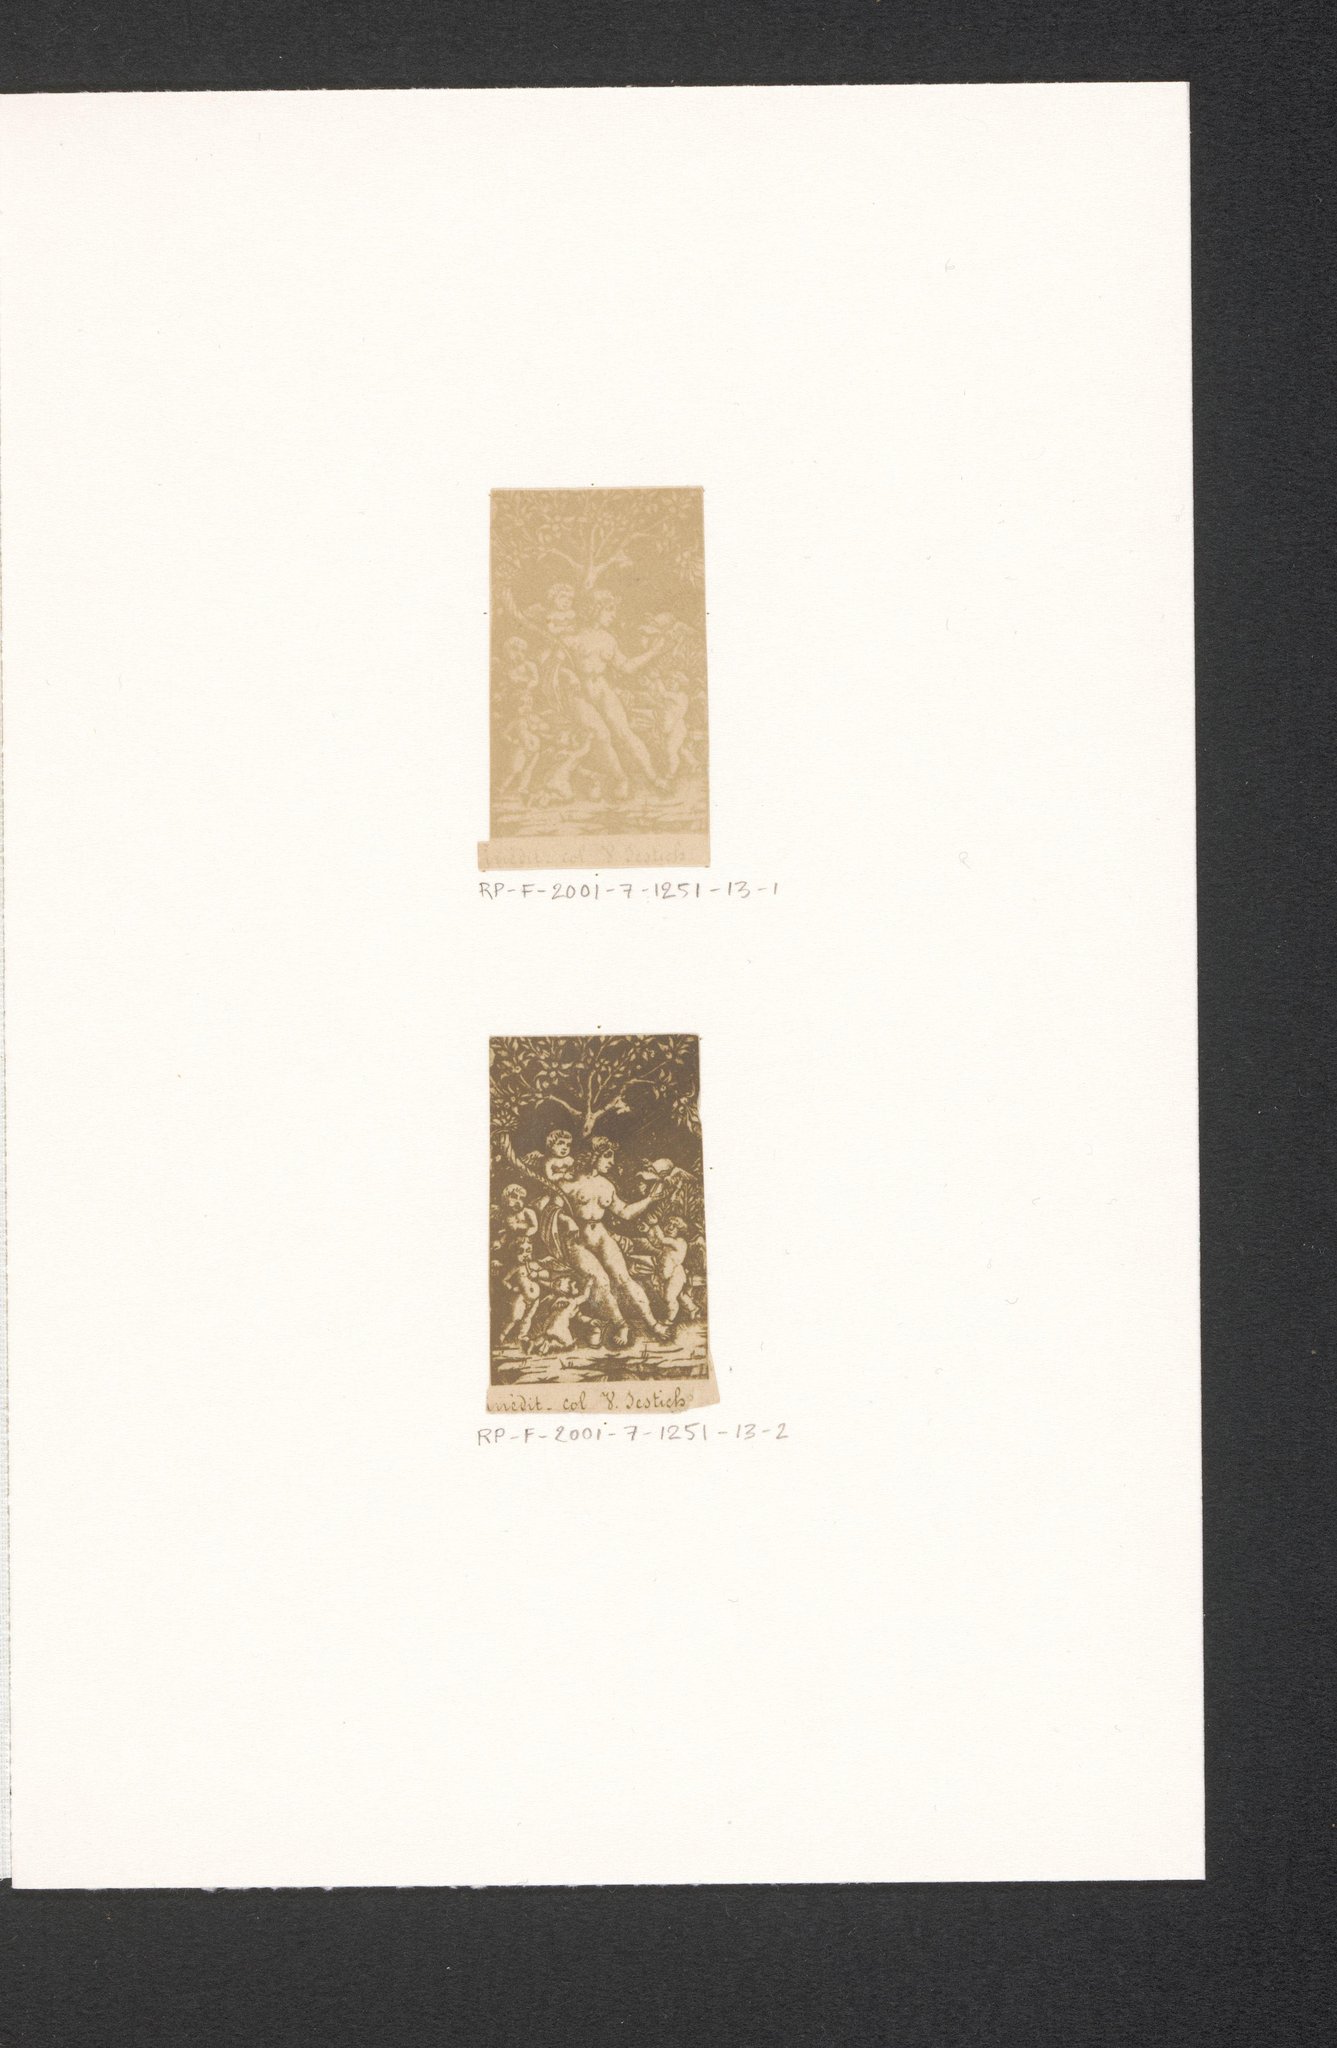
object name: page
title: Fotoreproductie van een prent van een vrouw en vijf genieën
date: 1852-1857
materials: photographic support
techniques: salted paper print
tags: adult woman, child, genius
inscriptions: inscription: ‘[medit.] col V. Sestich’